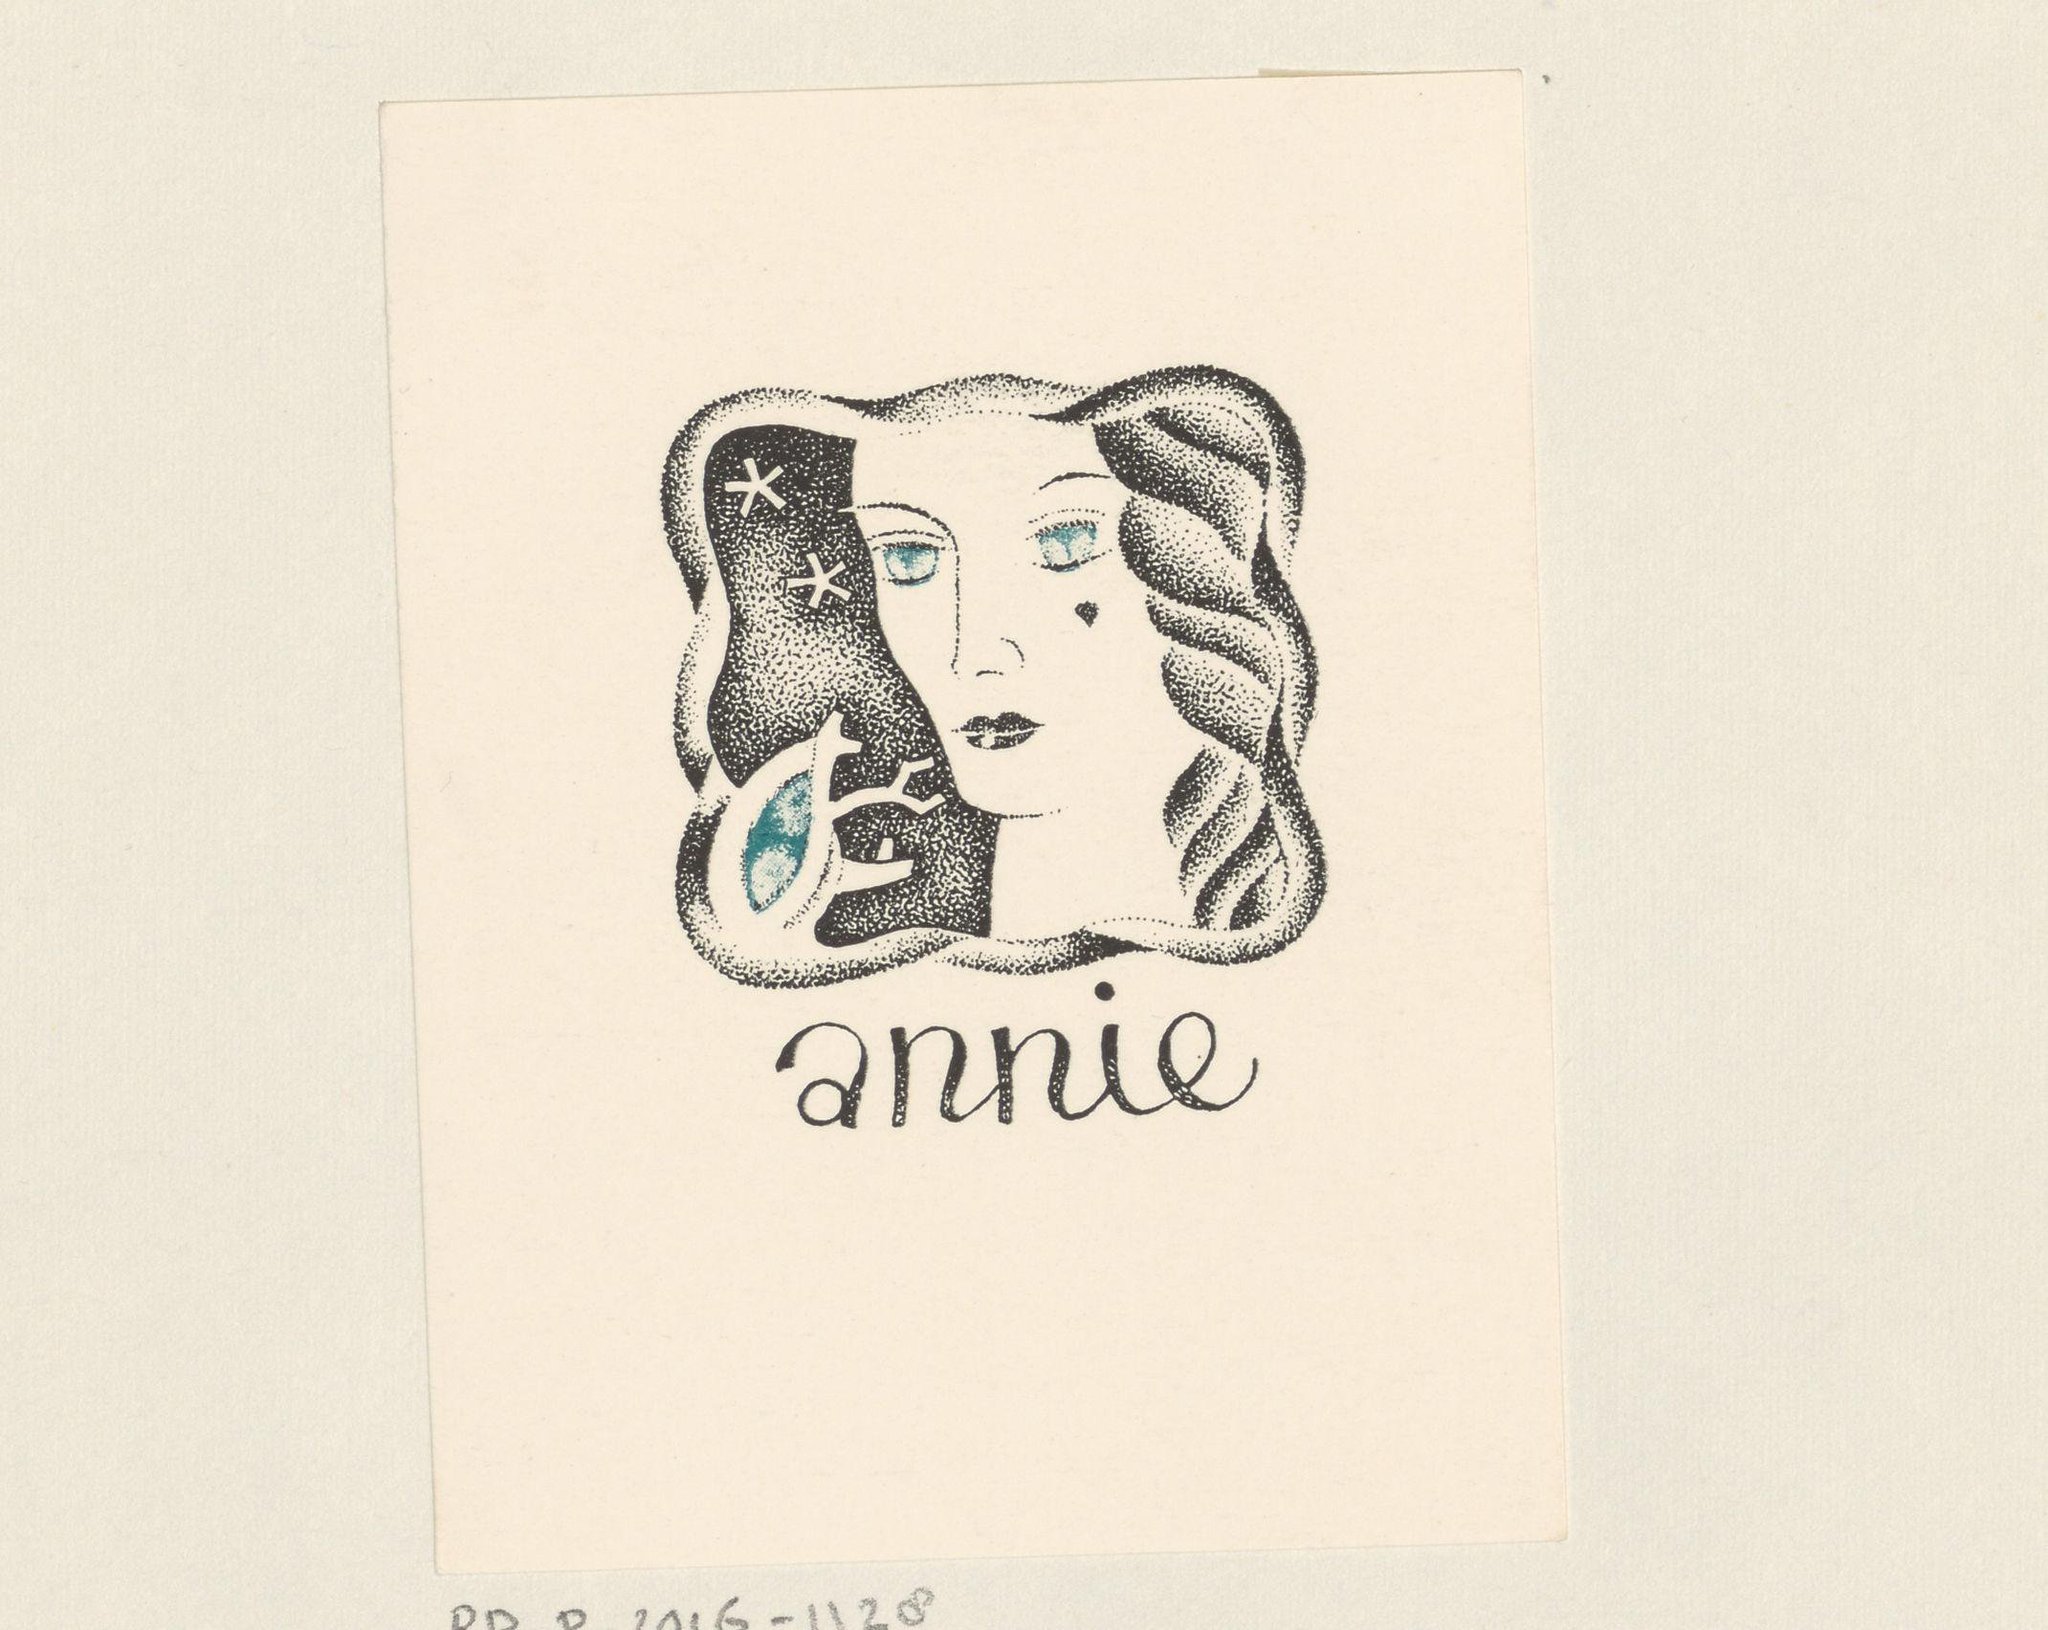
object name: bookplate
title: Ex libris van Annie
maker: Anonymous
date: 1920-1980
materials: paper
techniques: printing block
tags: branches, 'astwerk' ~ ornament